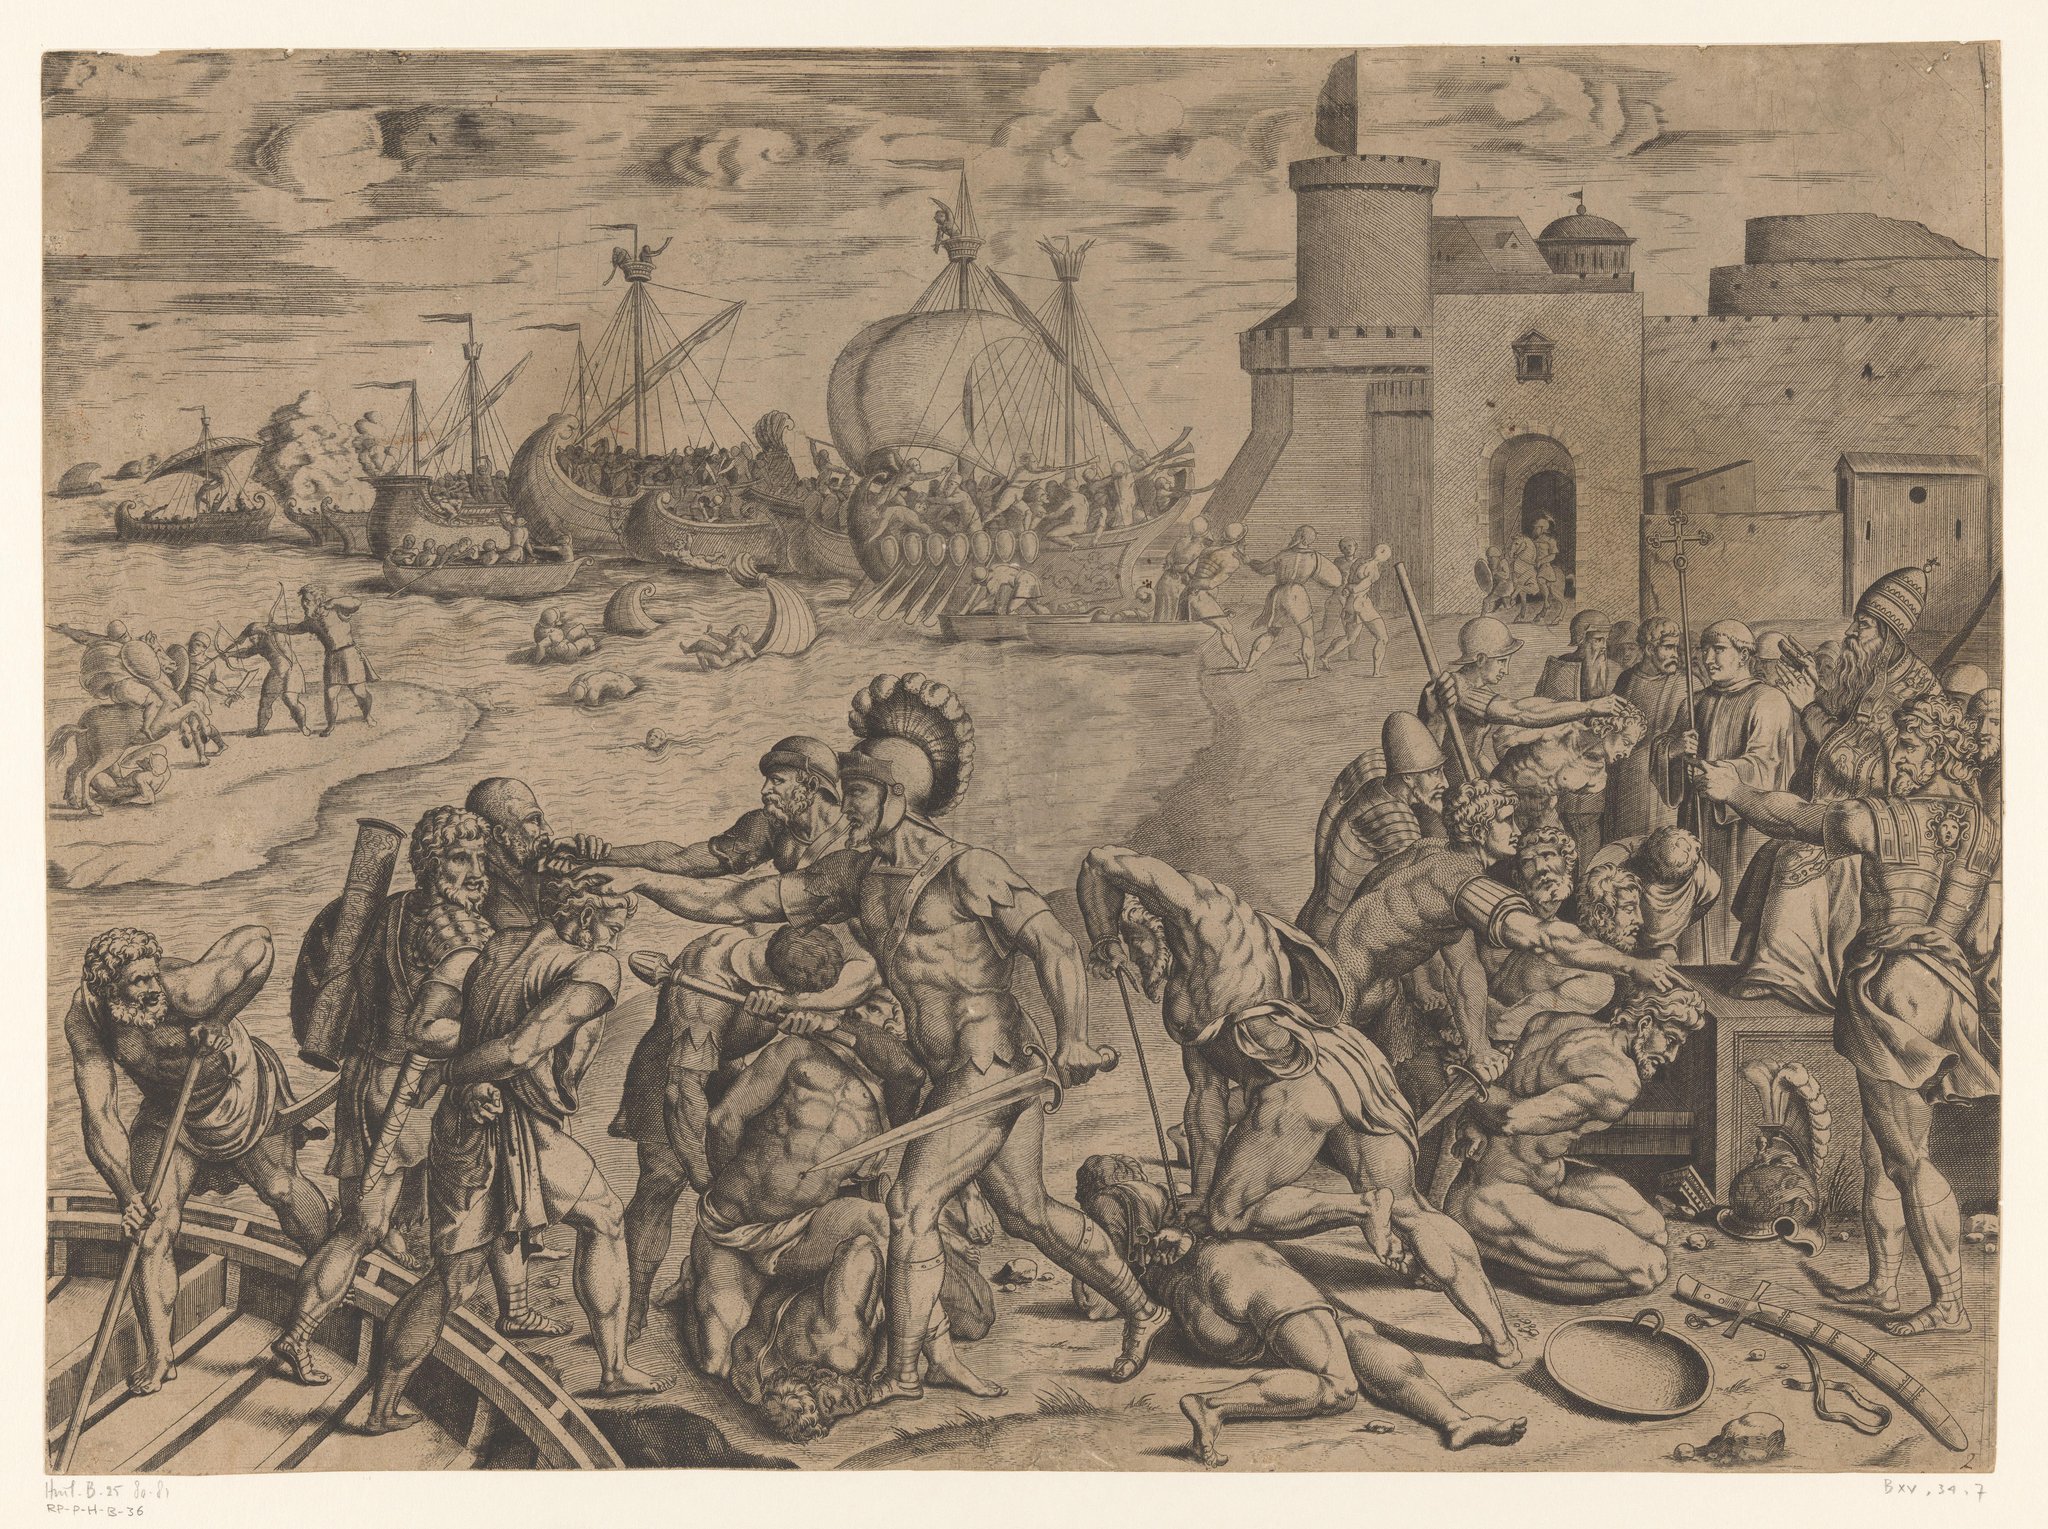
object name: print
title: Saracenen arriveren in Ostia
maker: Anonymous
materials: paper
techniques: engraving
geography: italy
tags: rome, harbour, battle, pope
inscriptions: collector's mark: ‘Hinloopen’, collector's mark: Lugt 10, collector's mark: Lugt 11, number: ‘2’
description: De vloot van de Saracenen arriveert in de havenstad Ostia, waar de Saracenen door de Christenen gevangen worden genomen. Rechts worden de gevangenen voor paus Leo IV gebracht.